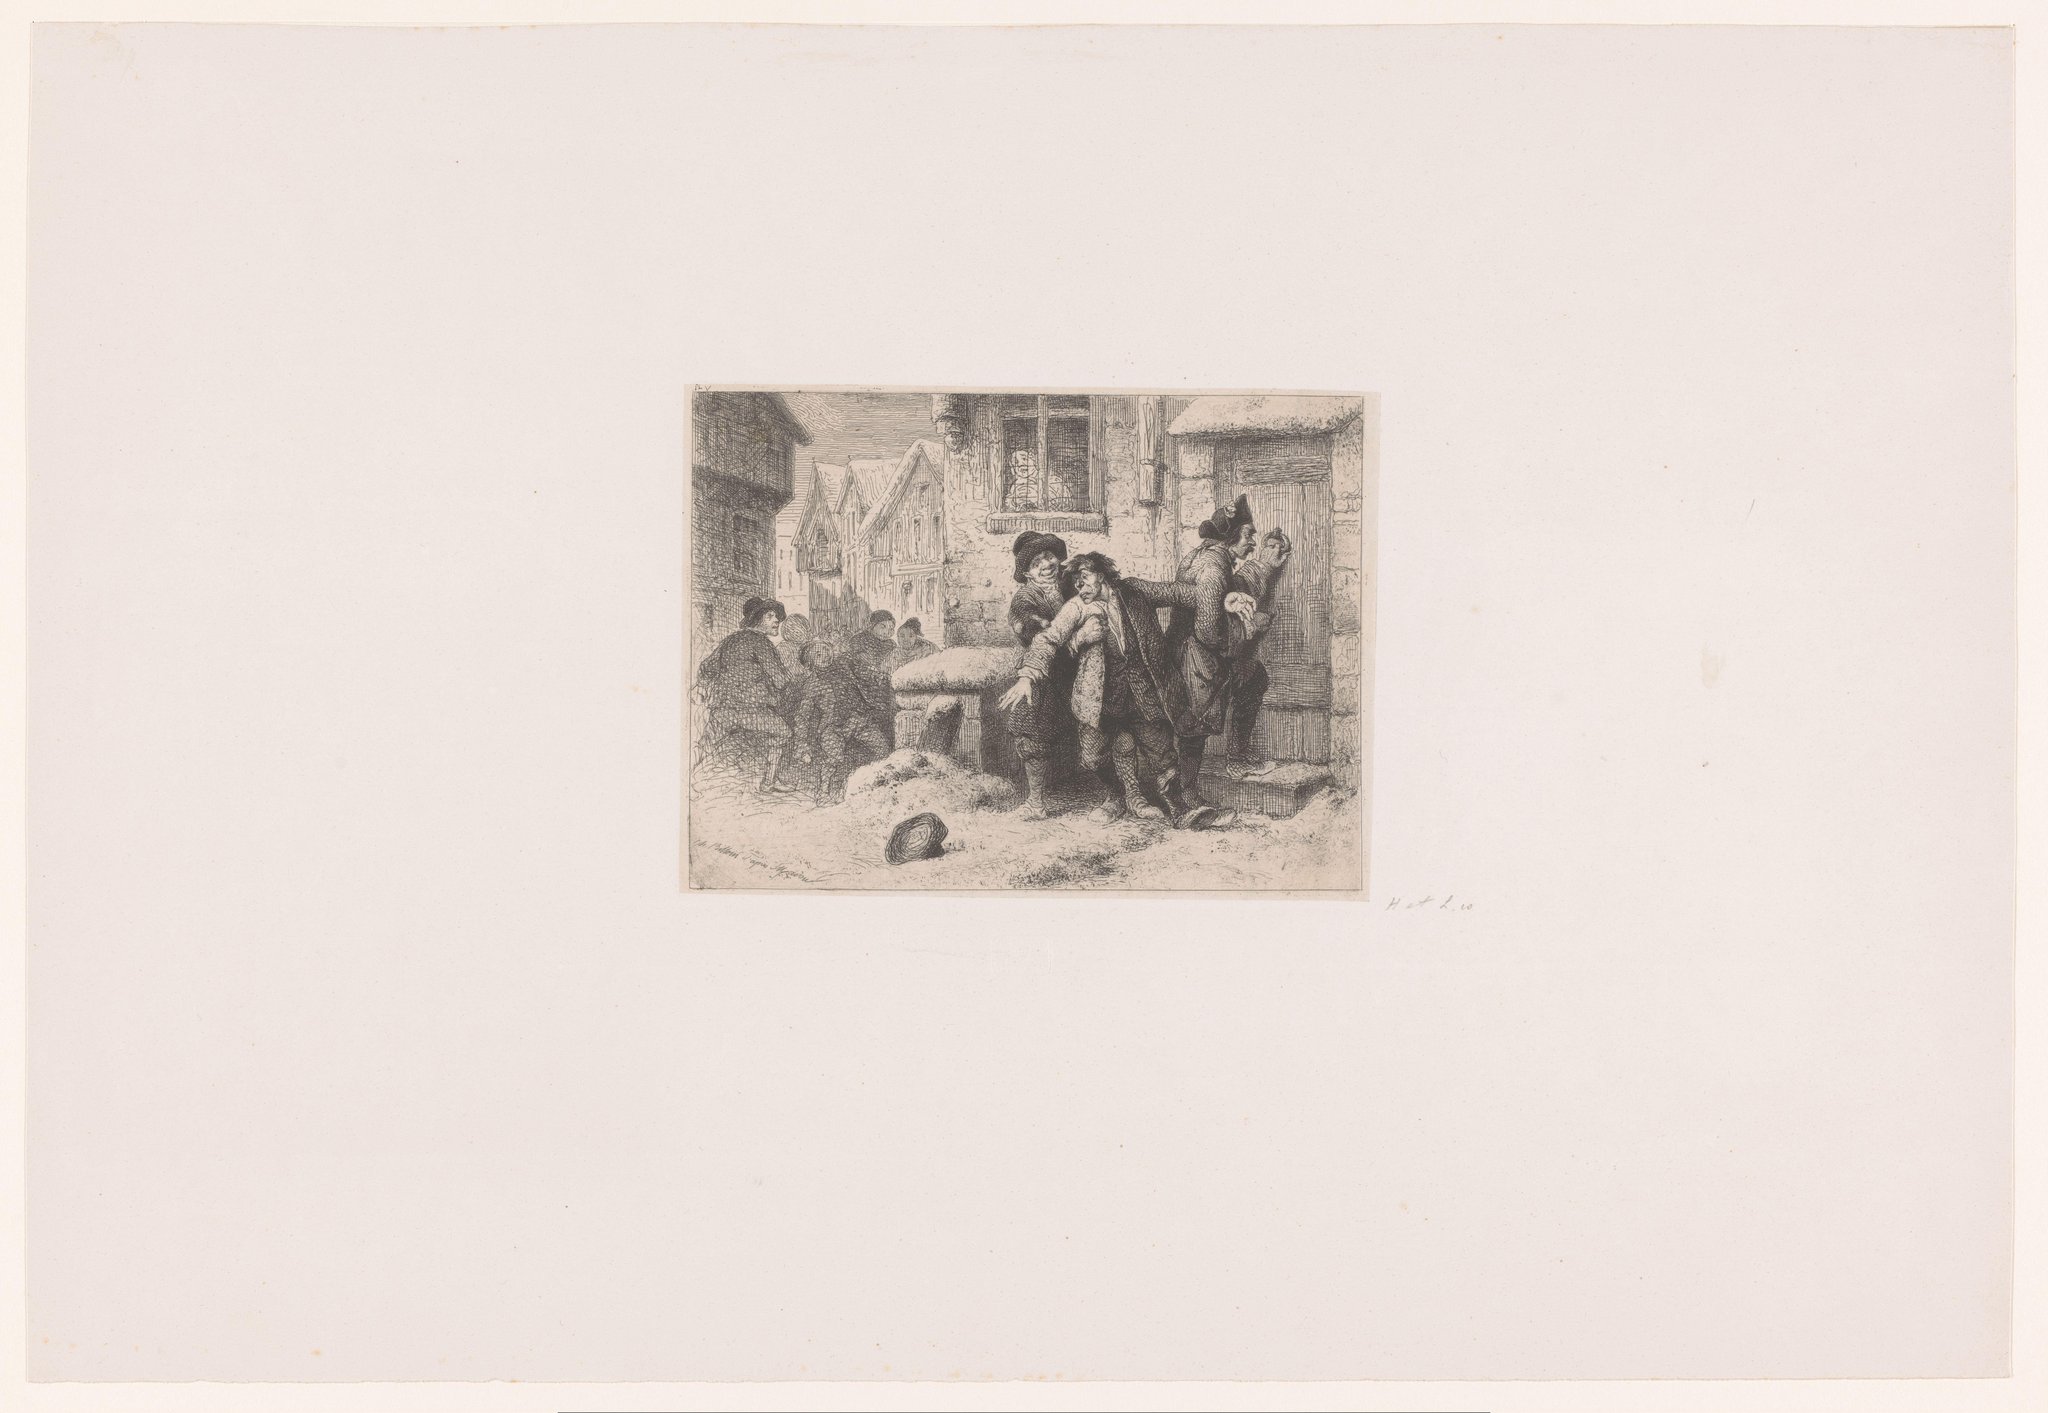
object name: print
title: Arrestatie van een dronken man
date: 1823-1869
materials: paper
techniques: etching, intaglio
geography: brussels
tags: alcoholism, arrest (of criminal)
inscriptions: collector's mark: Lugt 2165, collector's mark: Lugt 2228